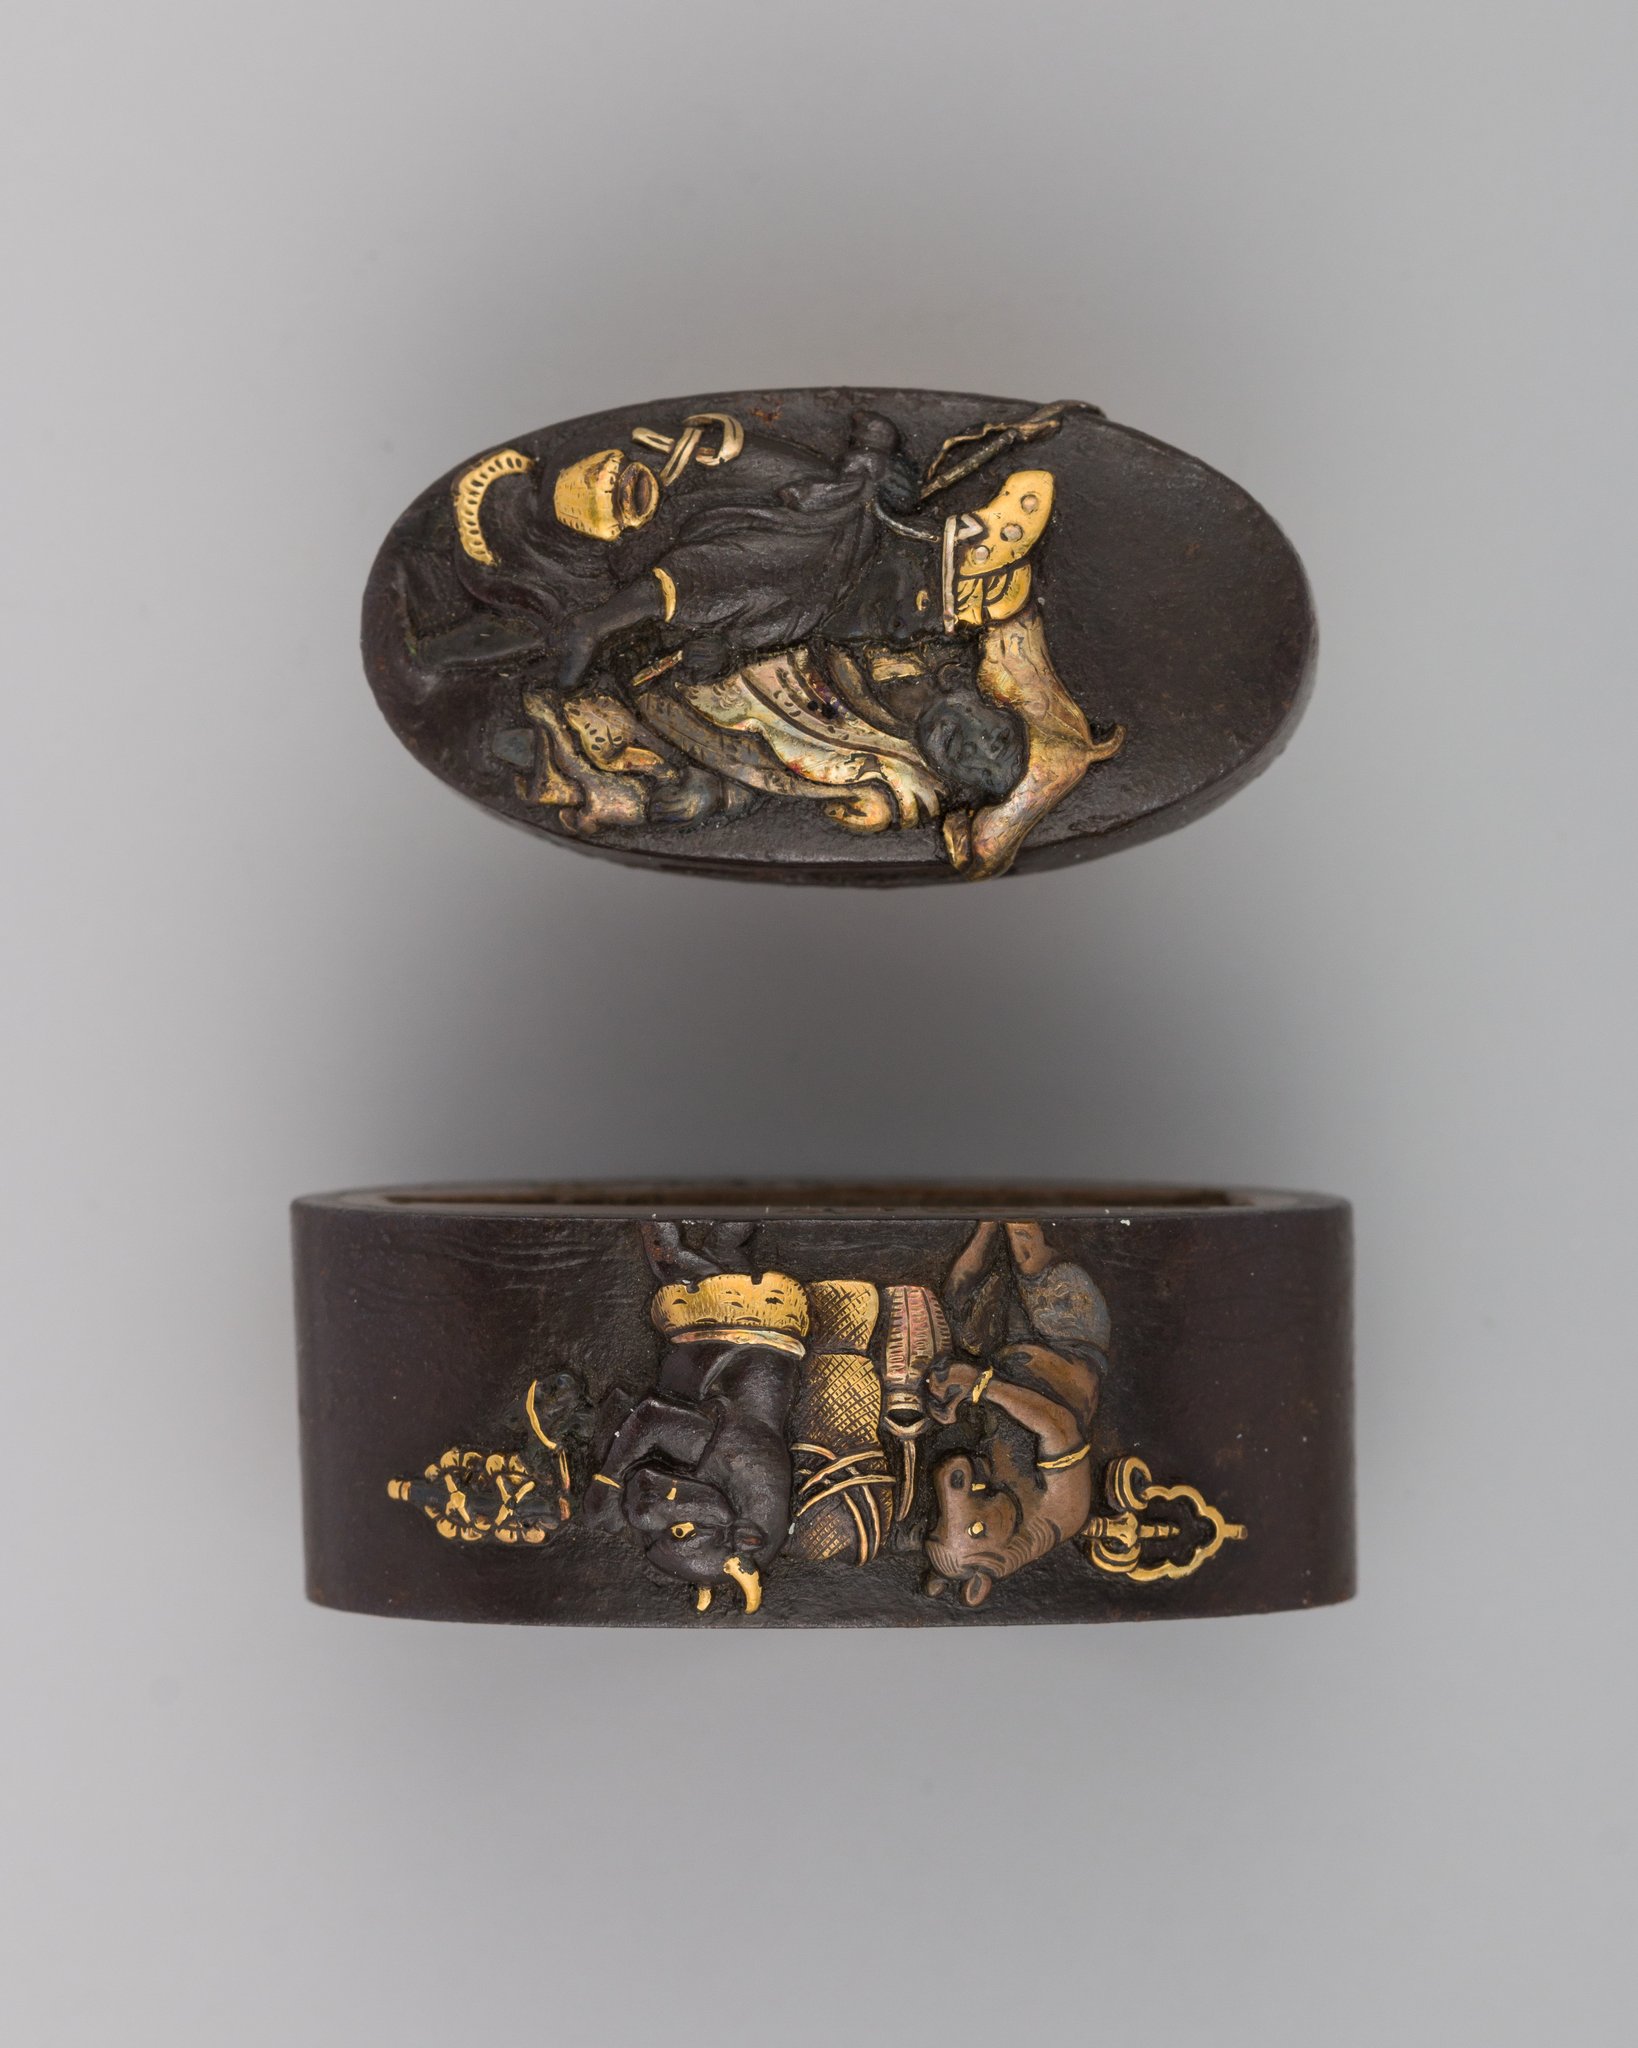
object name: sword hilt collar and pommel fuchigashira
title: Sword-Hilt Collar and Pommel (Fuchigashira)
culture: japanese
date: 1801-1900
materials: copper, silver alloy, gold, iron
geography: japan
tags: men,demons